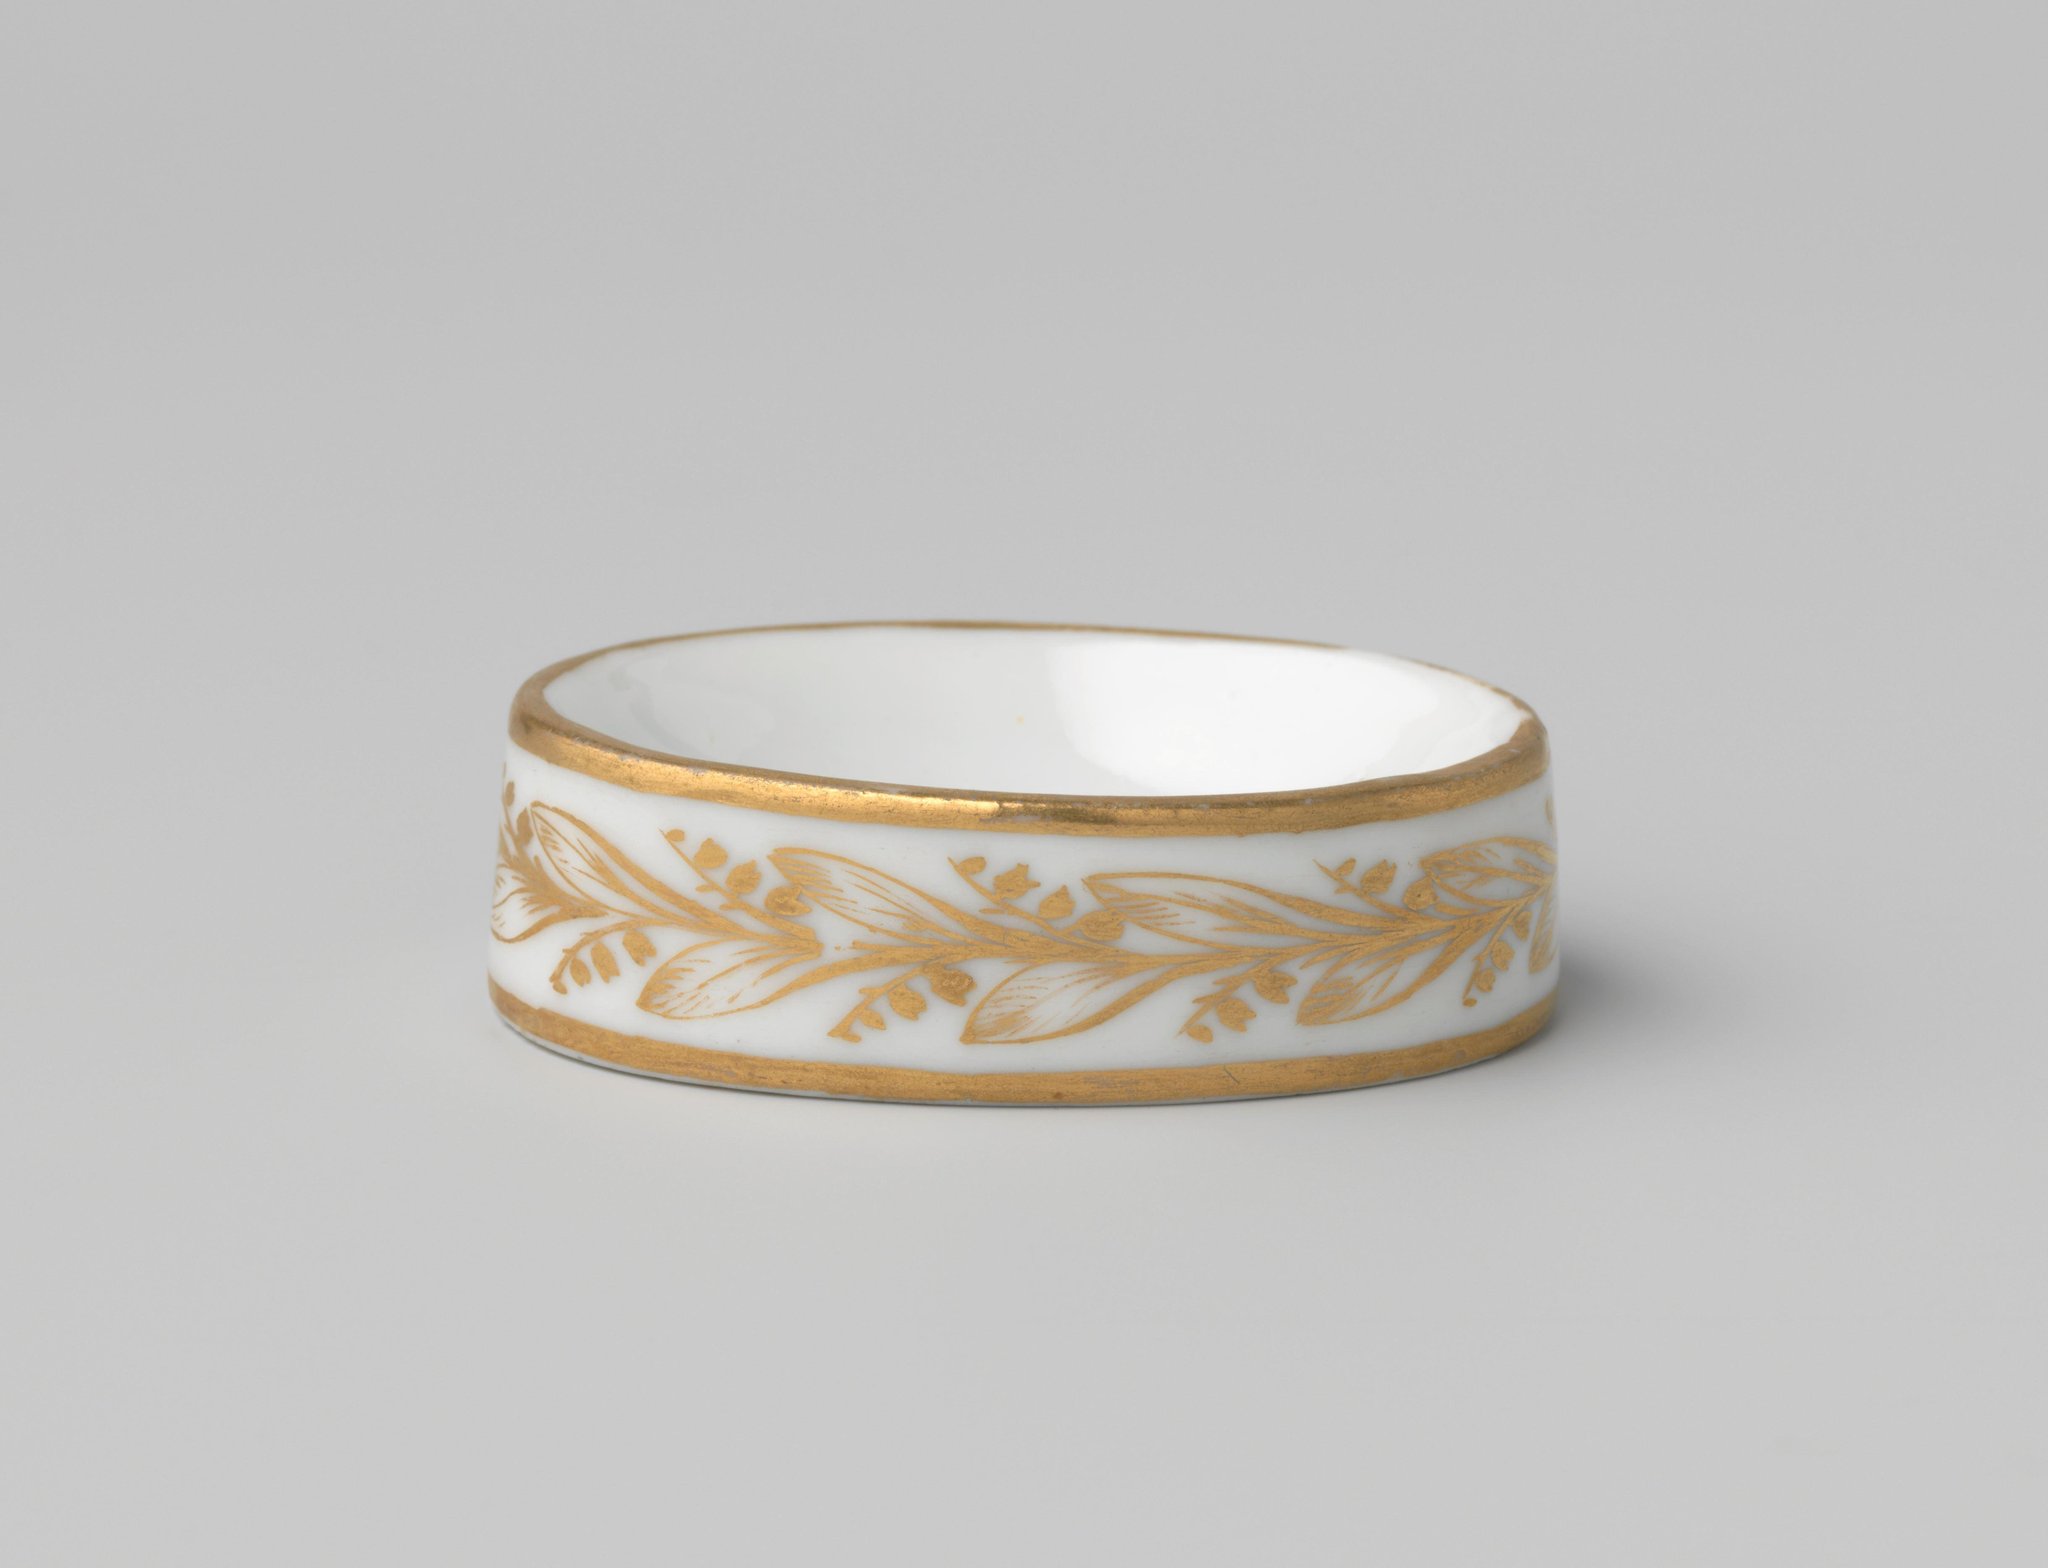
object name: salt condiment vessel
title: Salt with a floral scroll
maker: Anonymous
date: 1790-1800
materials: glaze, gold, paint, porcelain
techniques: firing, forming, gilding, turning, vitrification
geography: netherlands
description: Zoutvat, ovaal, van porselein, behorend bij een servies met versiering in goud van een bloem- en bladkrans en met het alliantiewapen van Hendrik Peter Godfried Quack en Isabella Gertraud von Carnap.